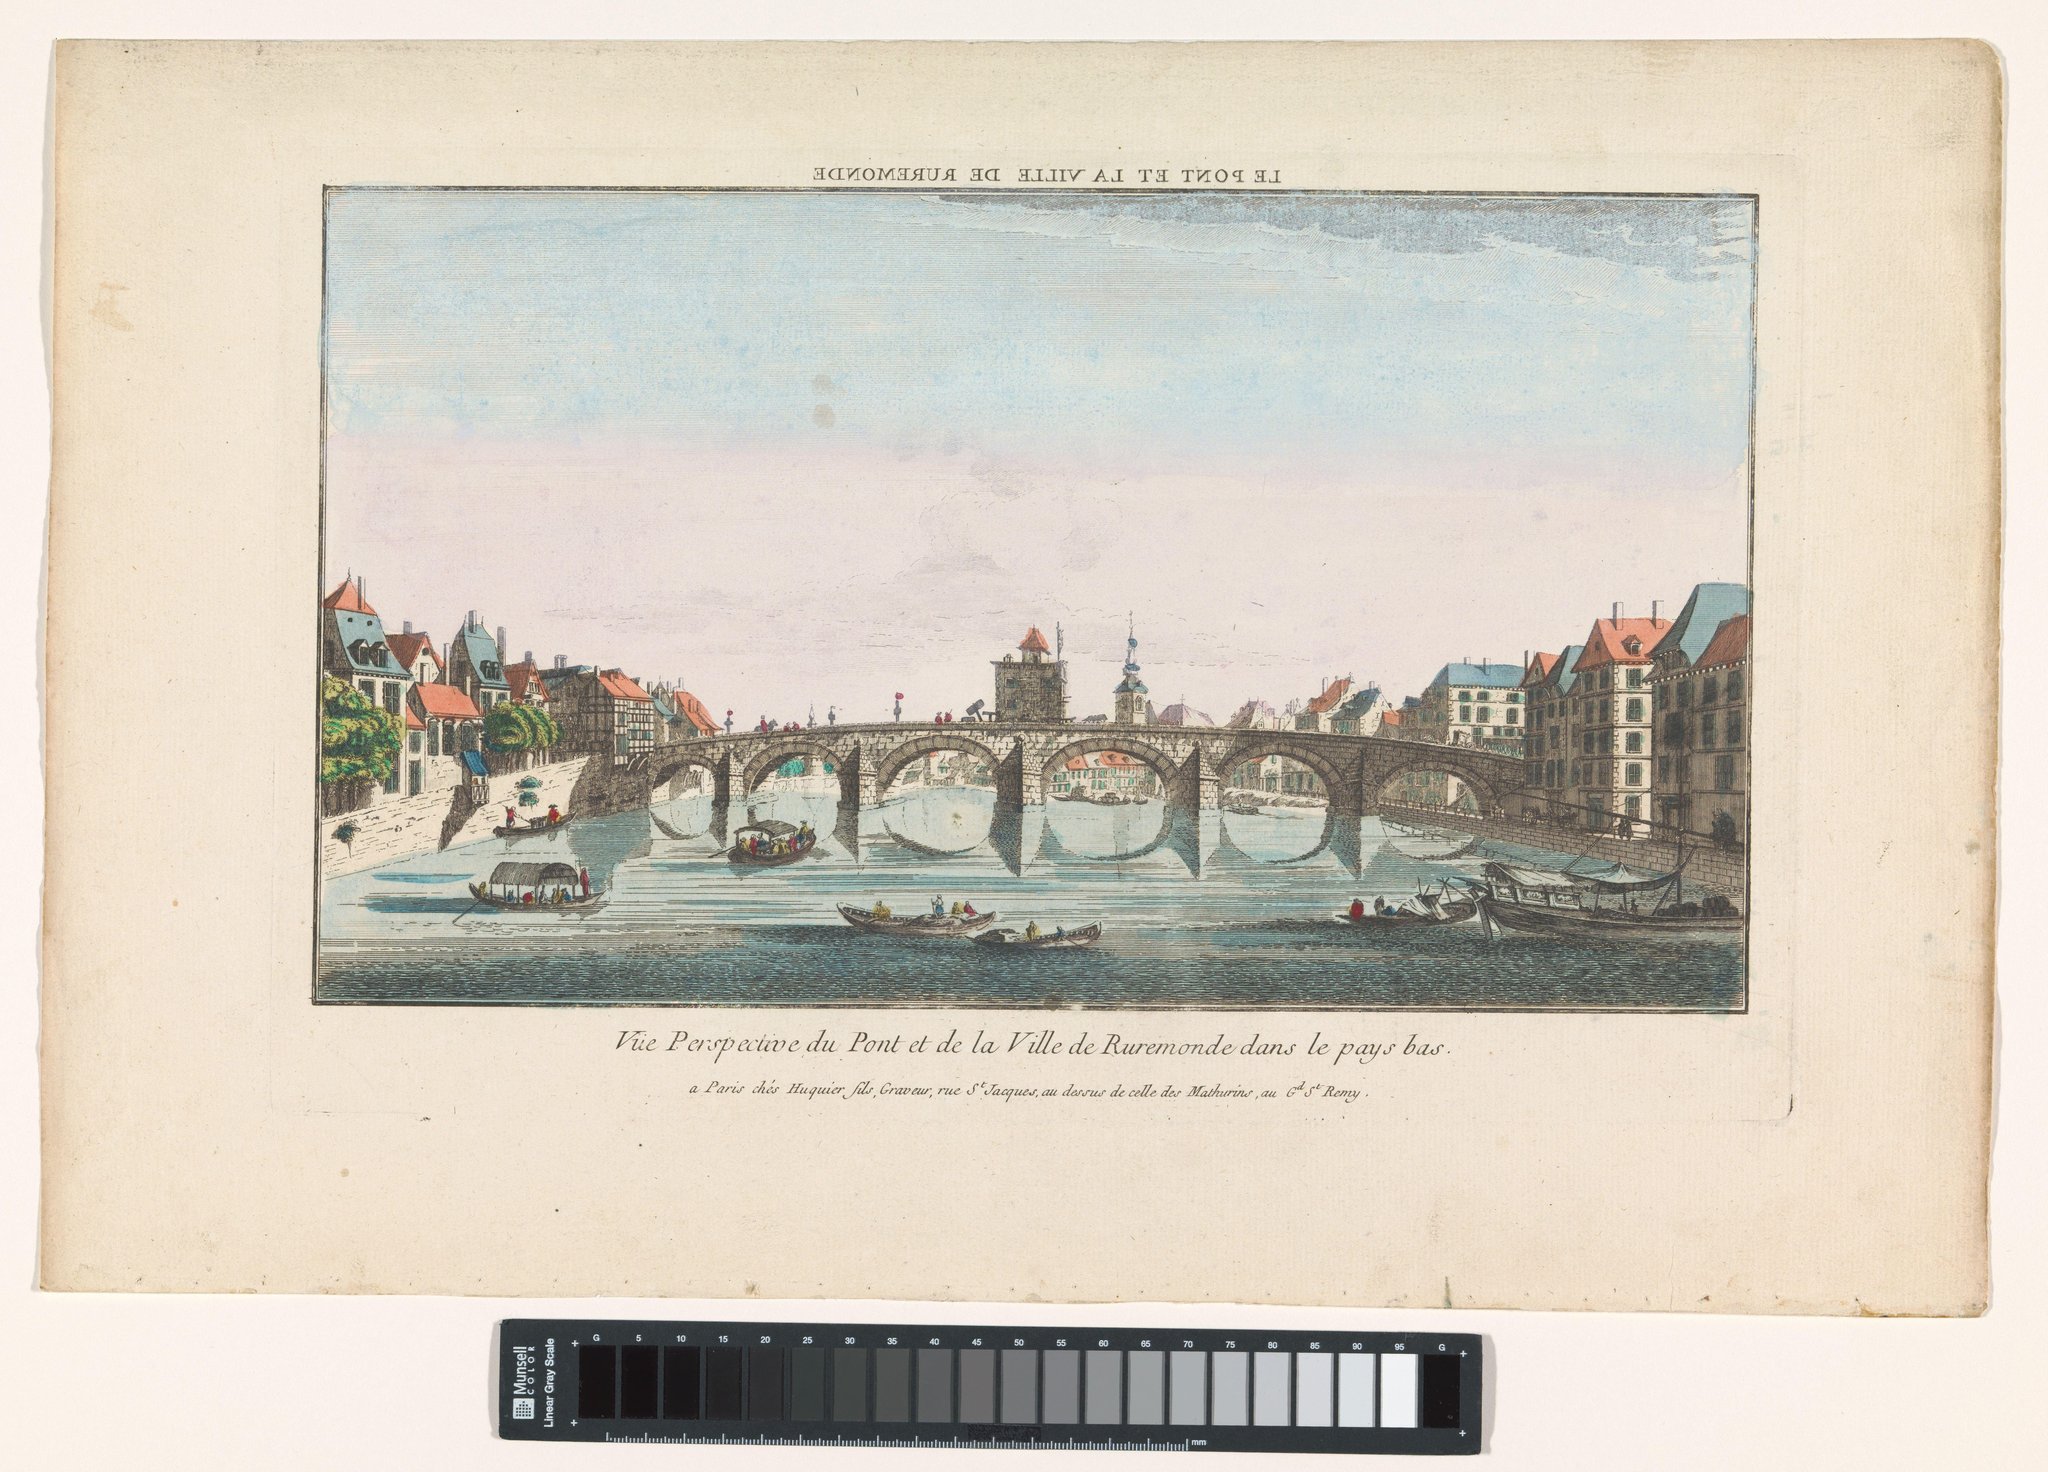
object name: opticaprent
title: Le pont et la ville de Ruremonde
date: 1735-1805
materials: paper, watercolor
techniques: brush, etching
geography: france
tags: bridge in city across river, canal, etc. (+ city(-scape) with figures, staffage), rowing-boat, canoe, etc.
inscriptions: watermark, collector's mark: Lugt 2166